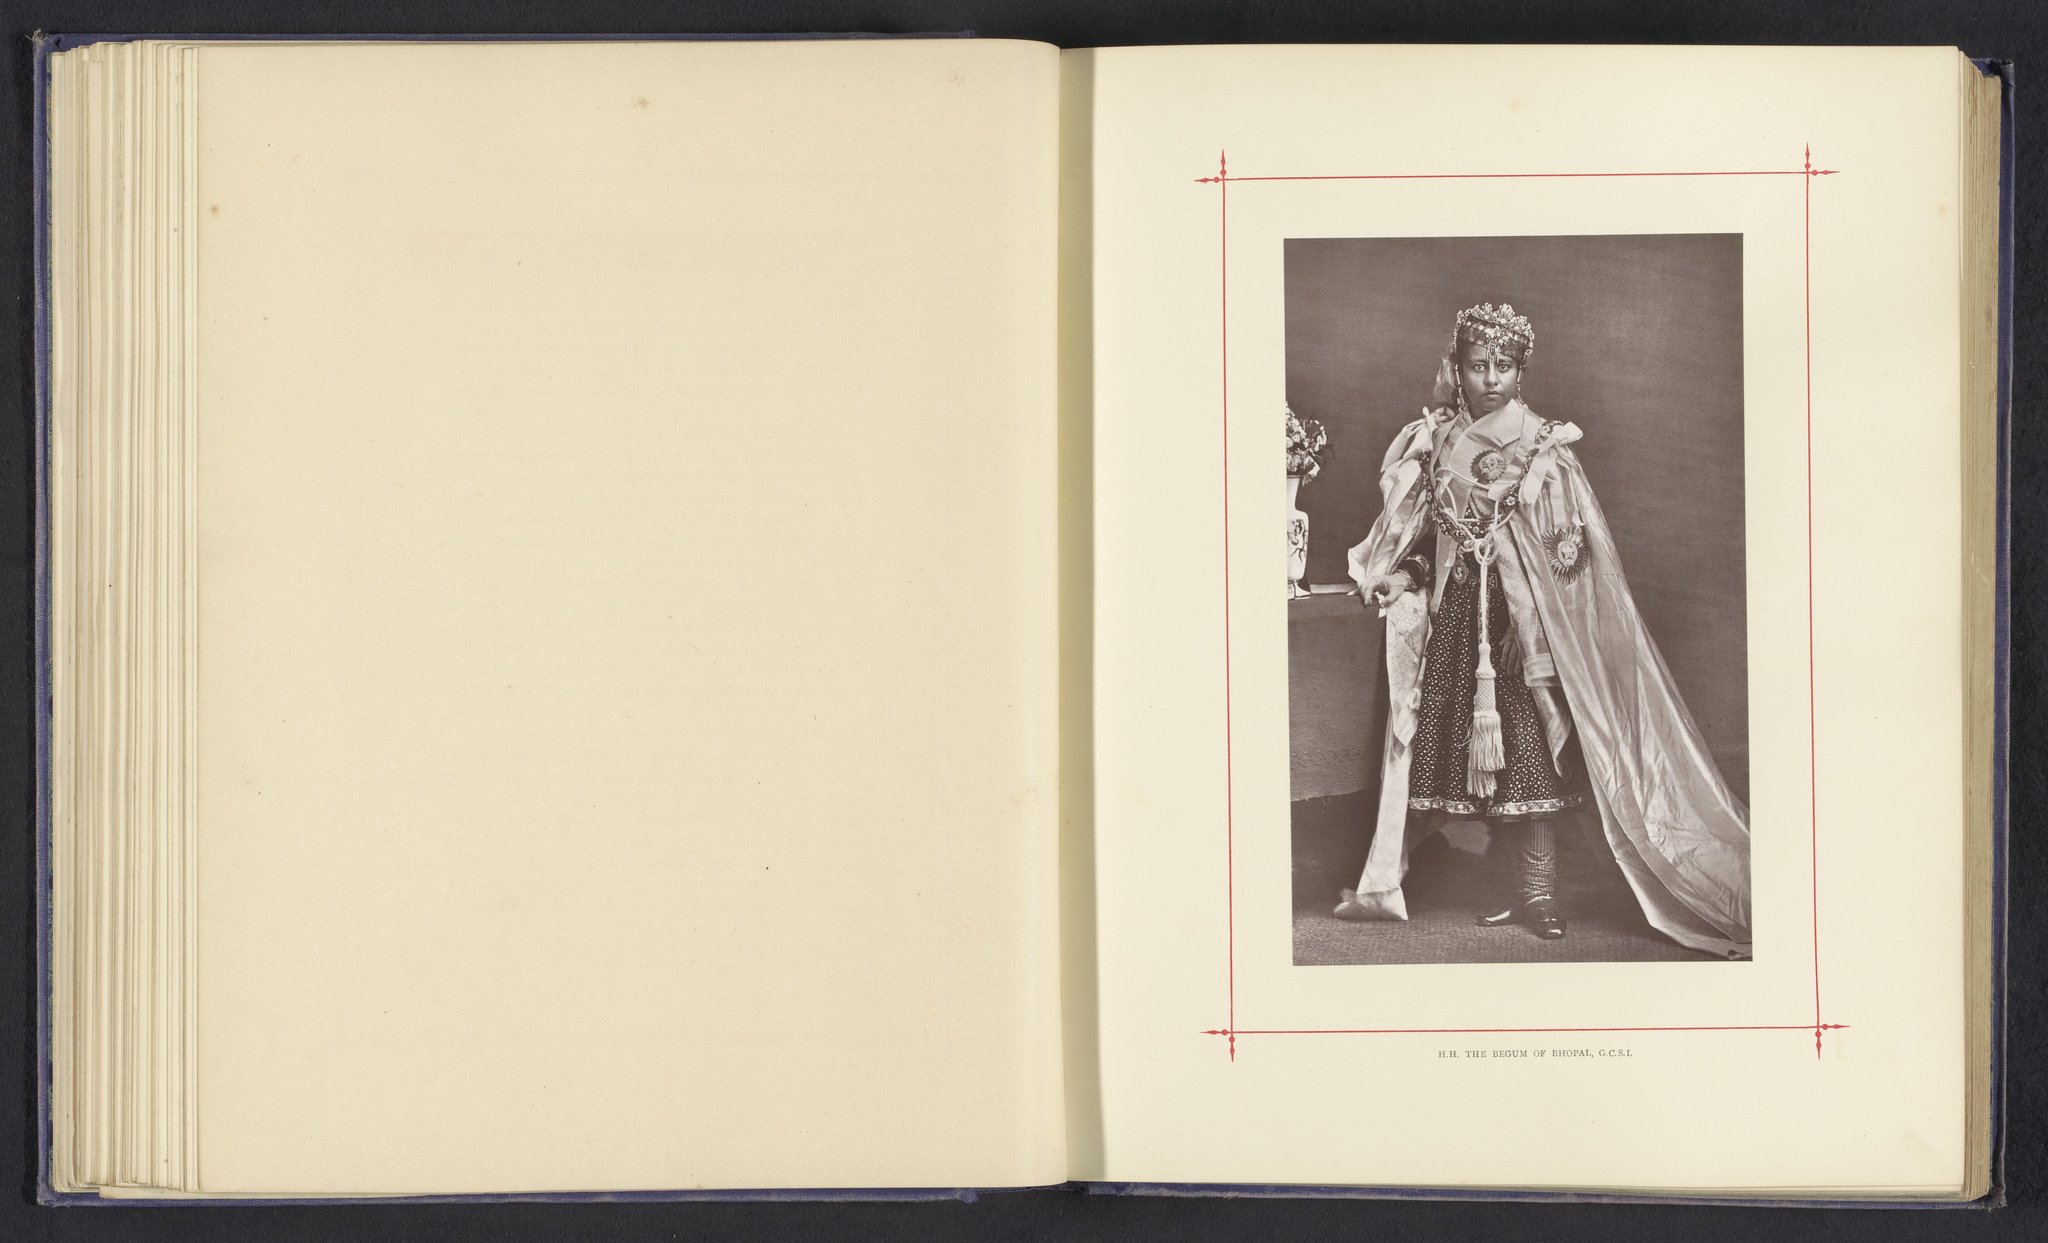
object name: page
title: Portret van Shah Jahan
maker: Anonymous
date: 1876-1877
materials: paper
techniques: woodburytype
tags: ruler, sovereign - bb - female ruler